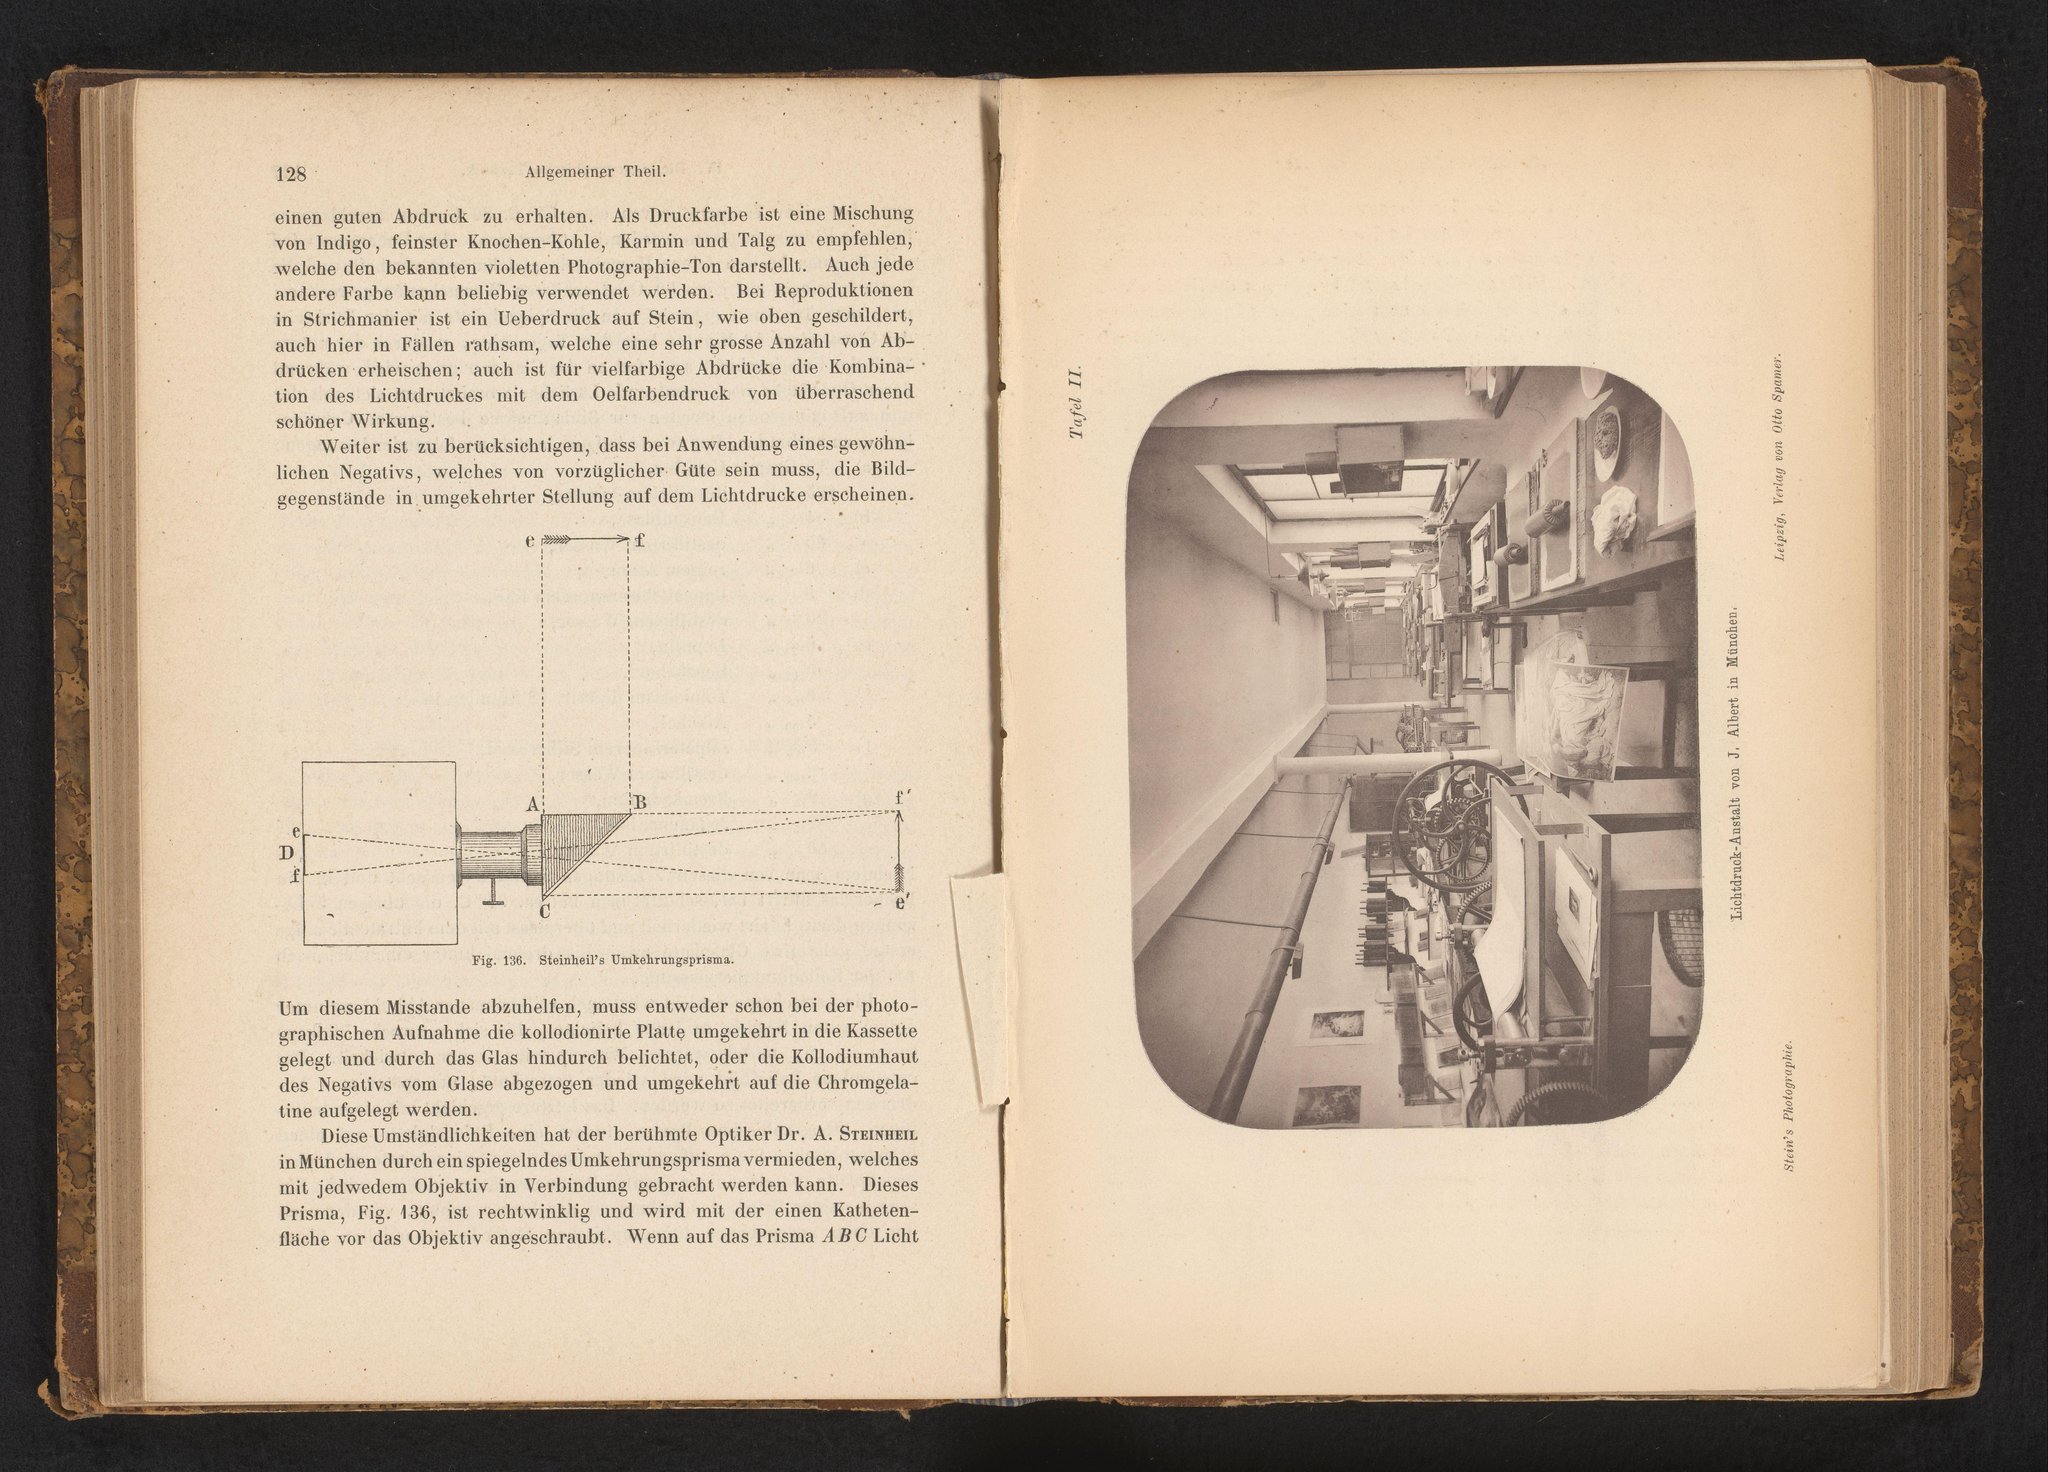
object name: page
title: Interieur van de lichtdrukstudio van Joseph Albert te München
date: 1867-1877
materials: paper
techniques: photograph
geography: dresden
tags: printing, printing office, interior ~ representation of a building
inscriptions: number: ‘Taf. II.’